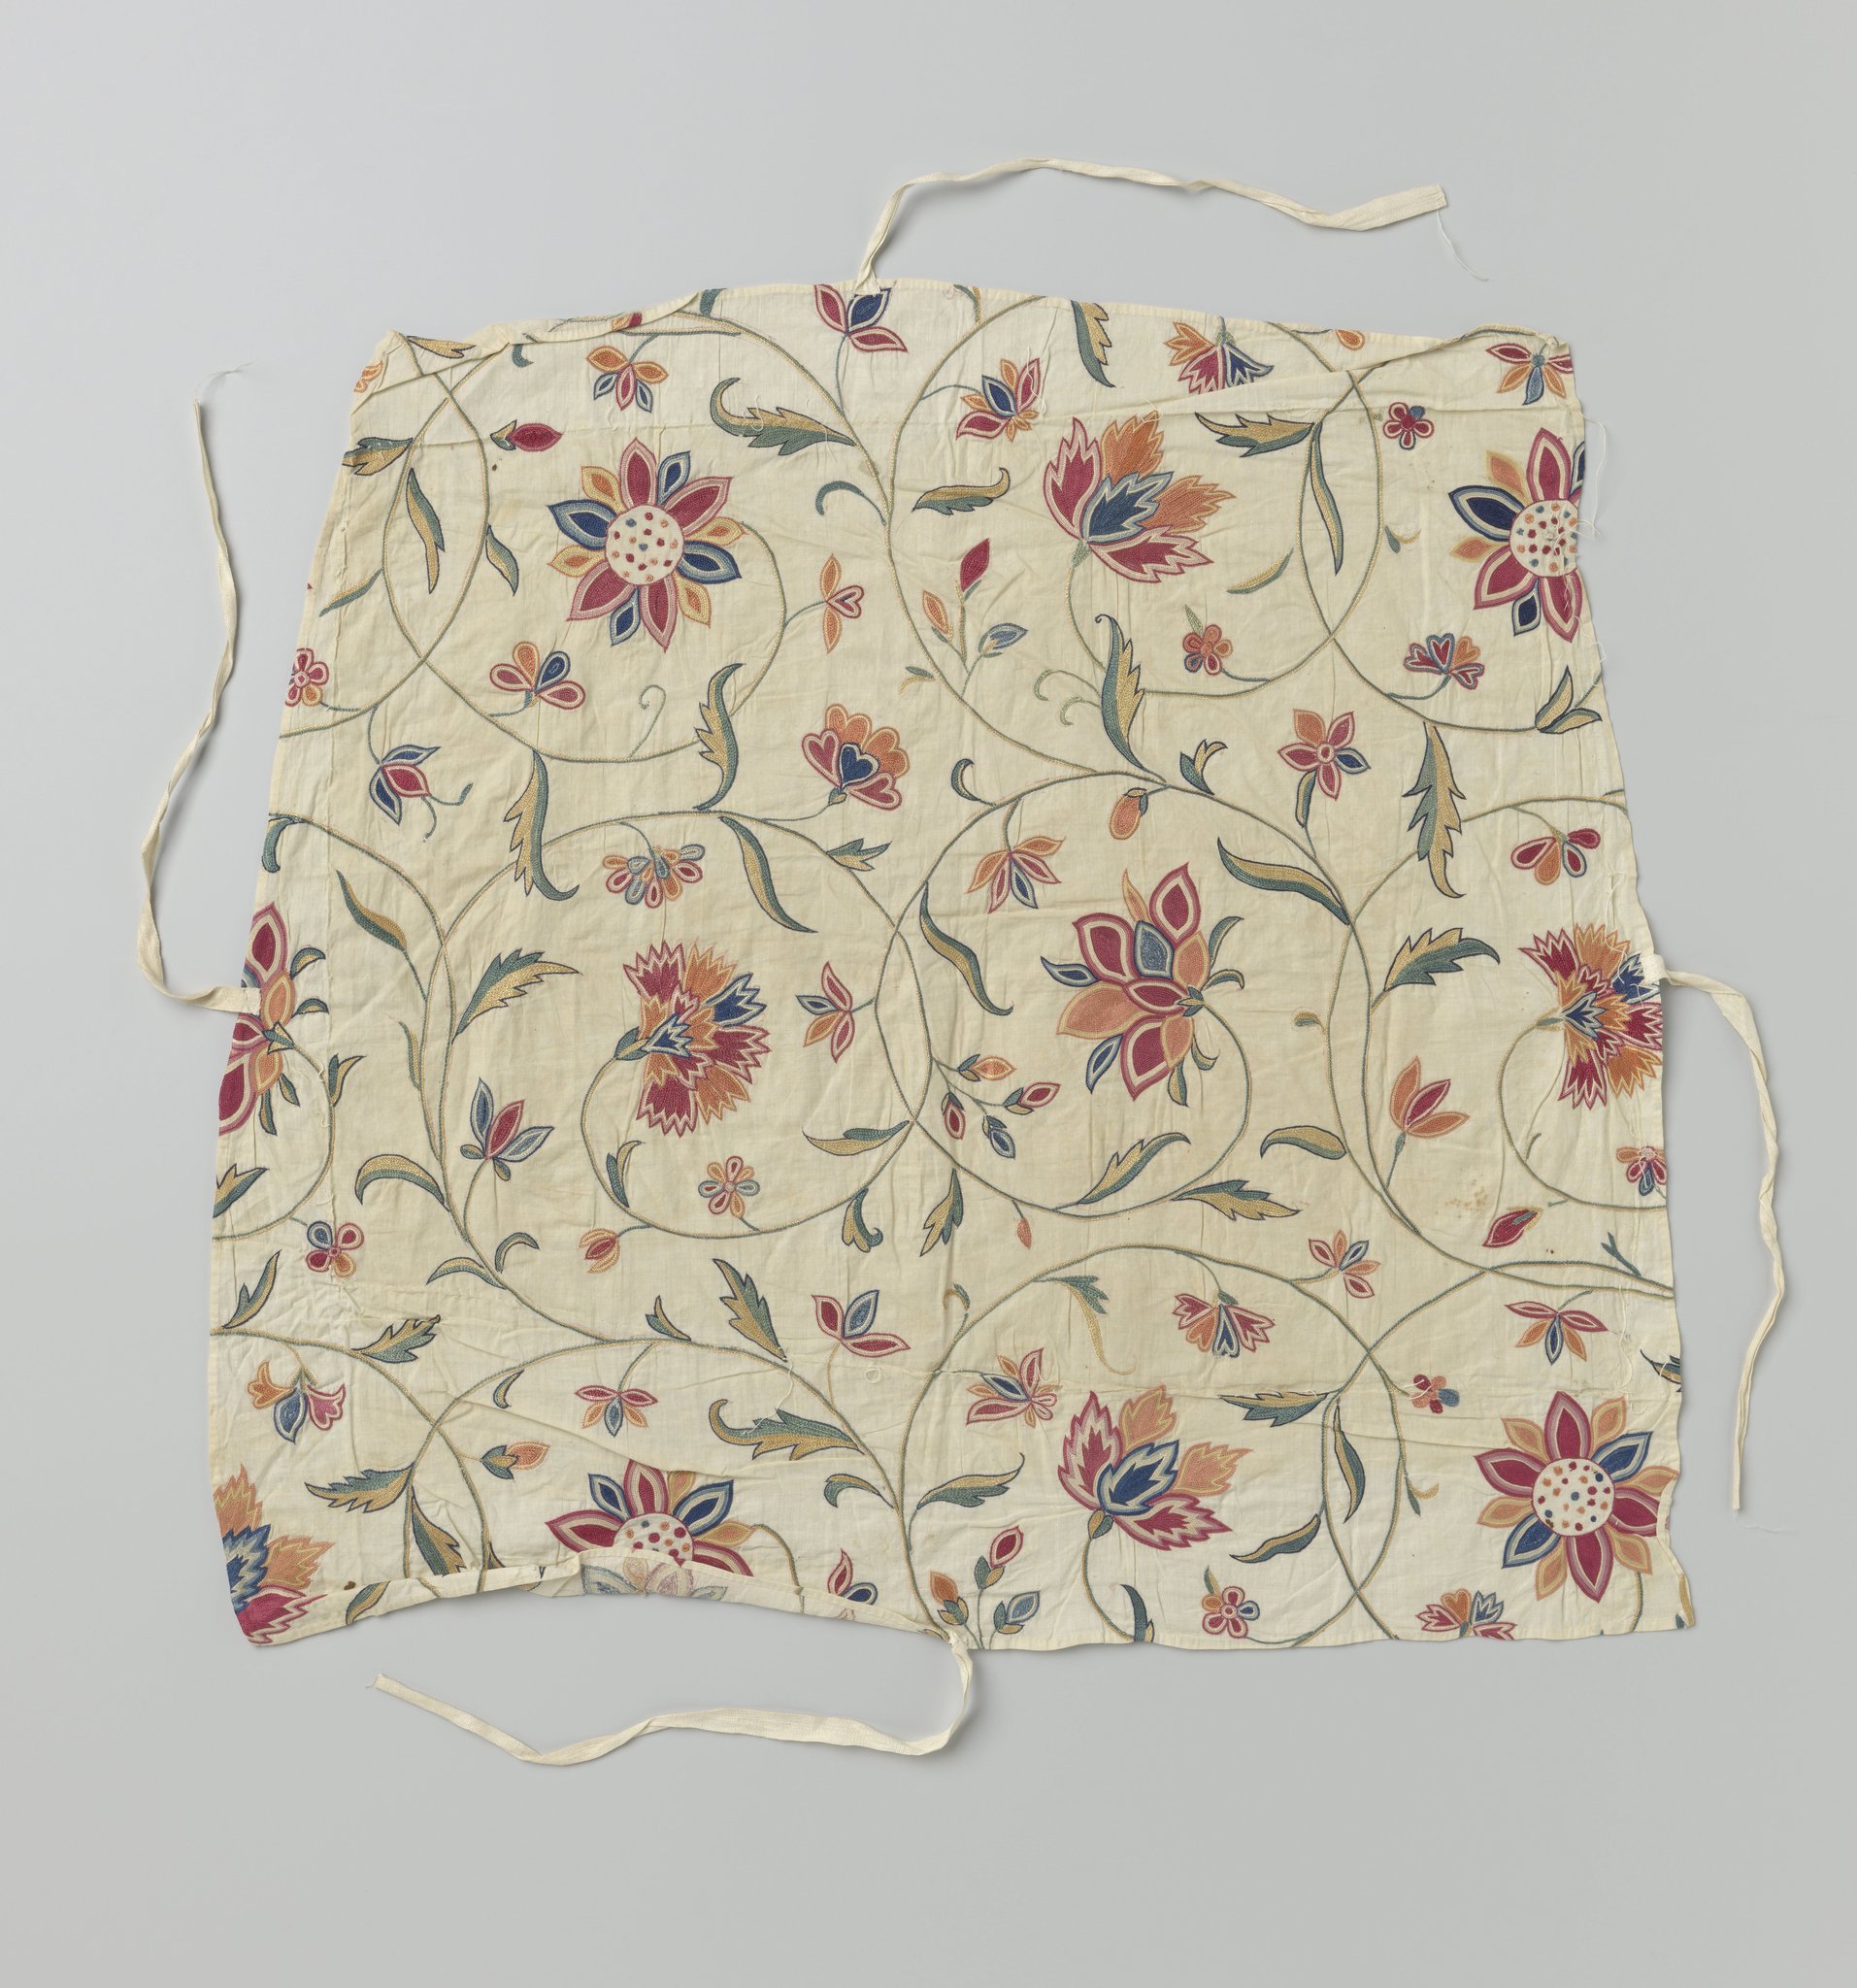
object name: textile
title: Fragment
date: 1690-1710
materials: cotton, silk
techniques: embroidered, weave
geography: east indies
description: Originally a bedspread, this fragment was repurposed into a chair cover in the course of time. It is decorated with a lotus blossom and carnation pattern in Indo-Persian style. Reusing fabric was common practice in the 18th century. For example, remnants of costly chintz were used for decorating doll’s houses, or as clothing for dolls and babies.